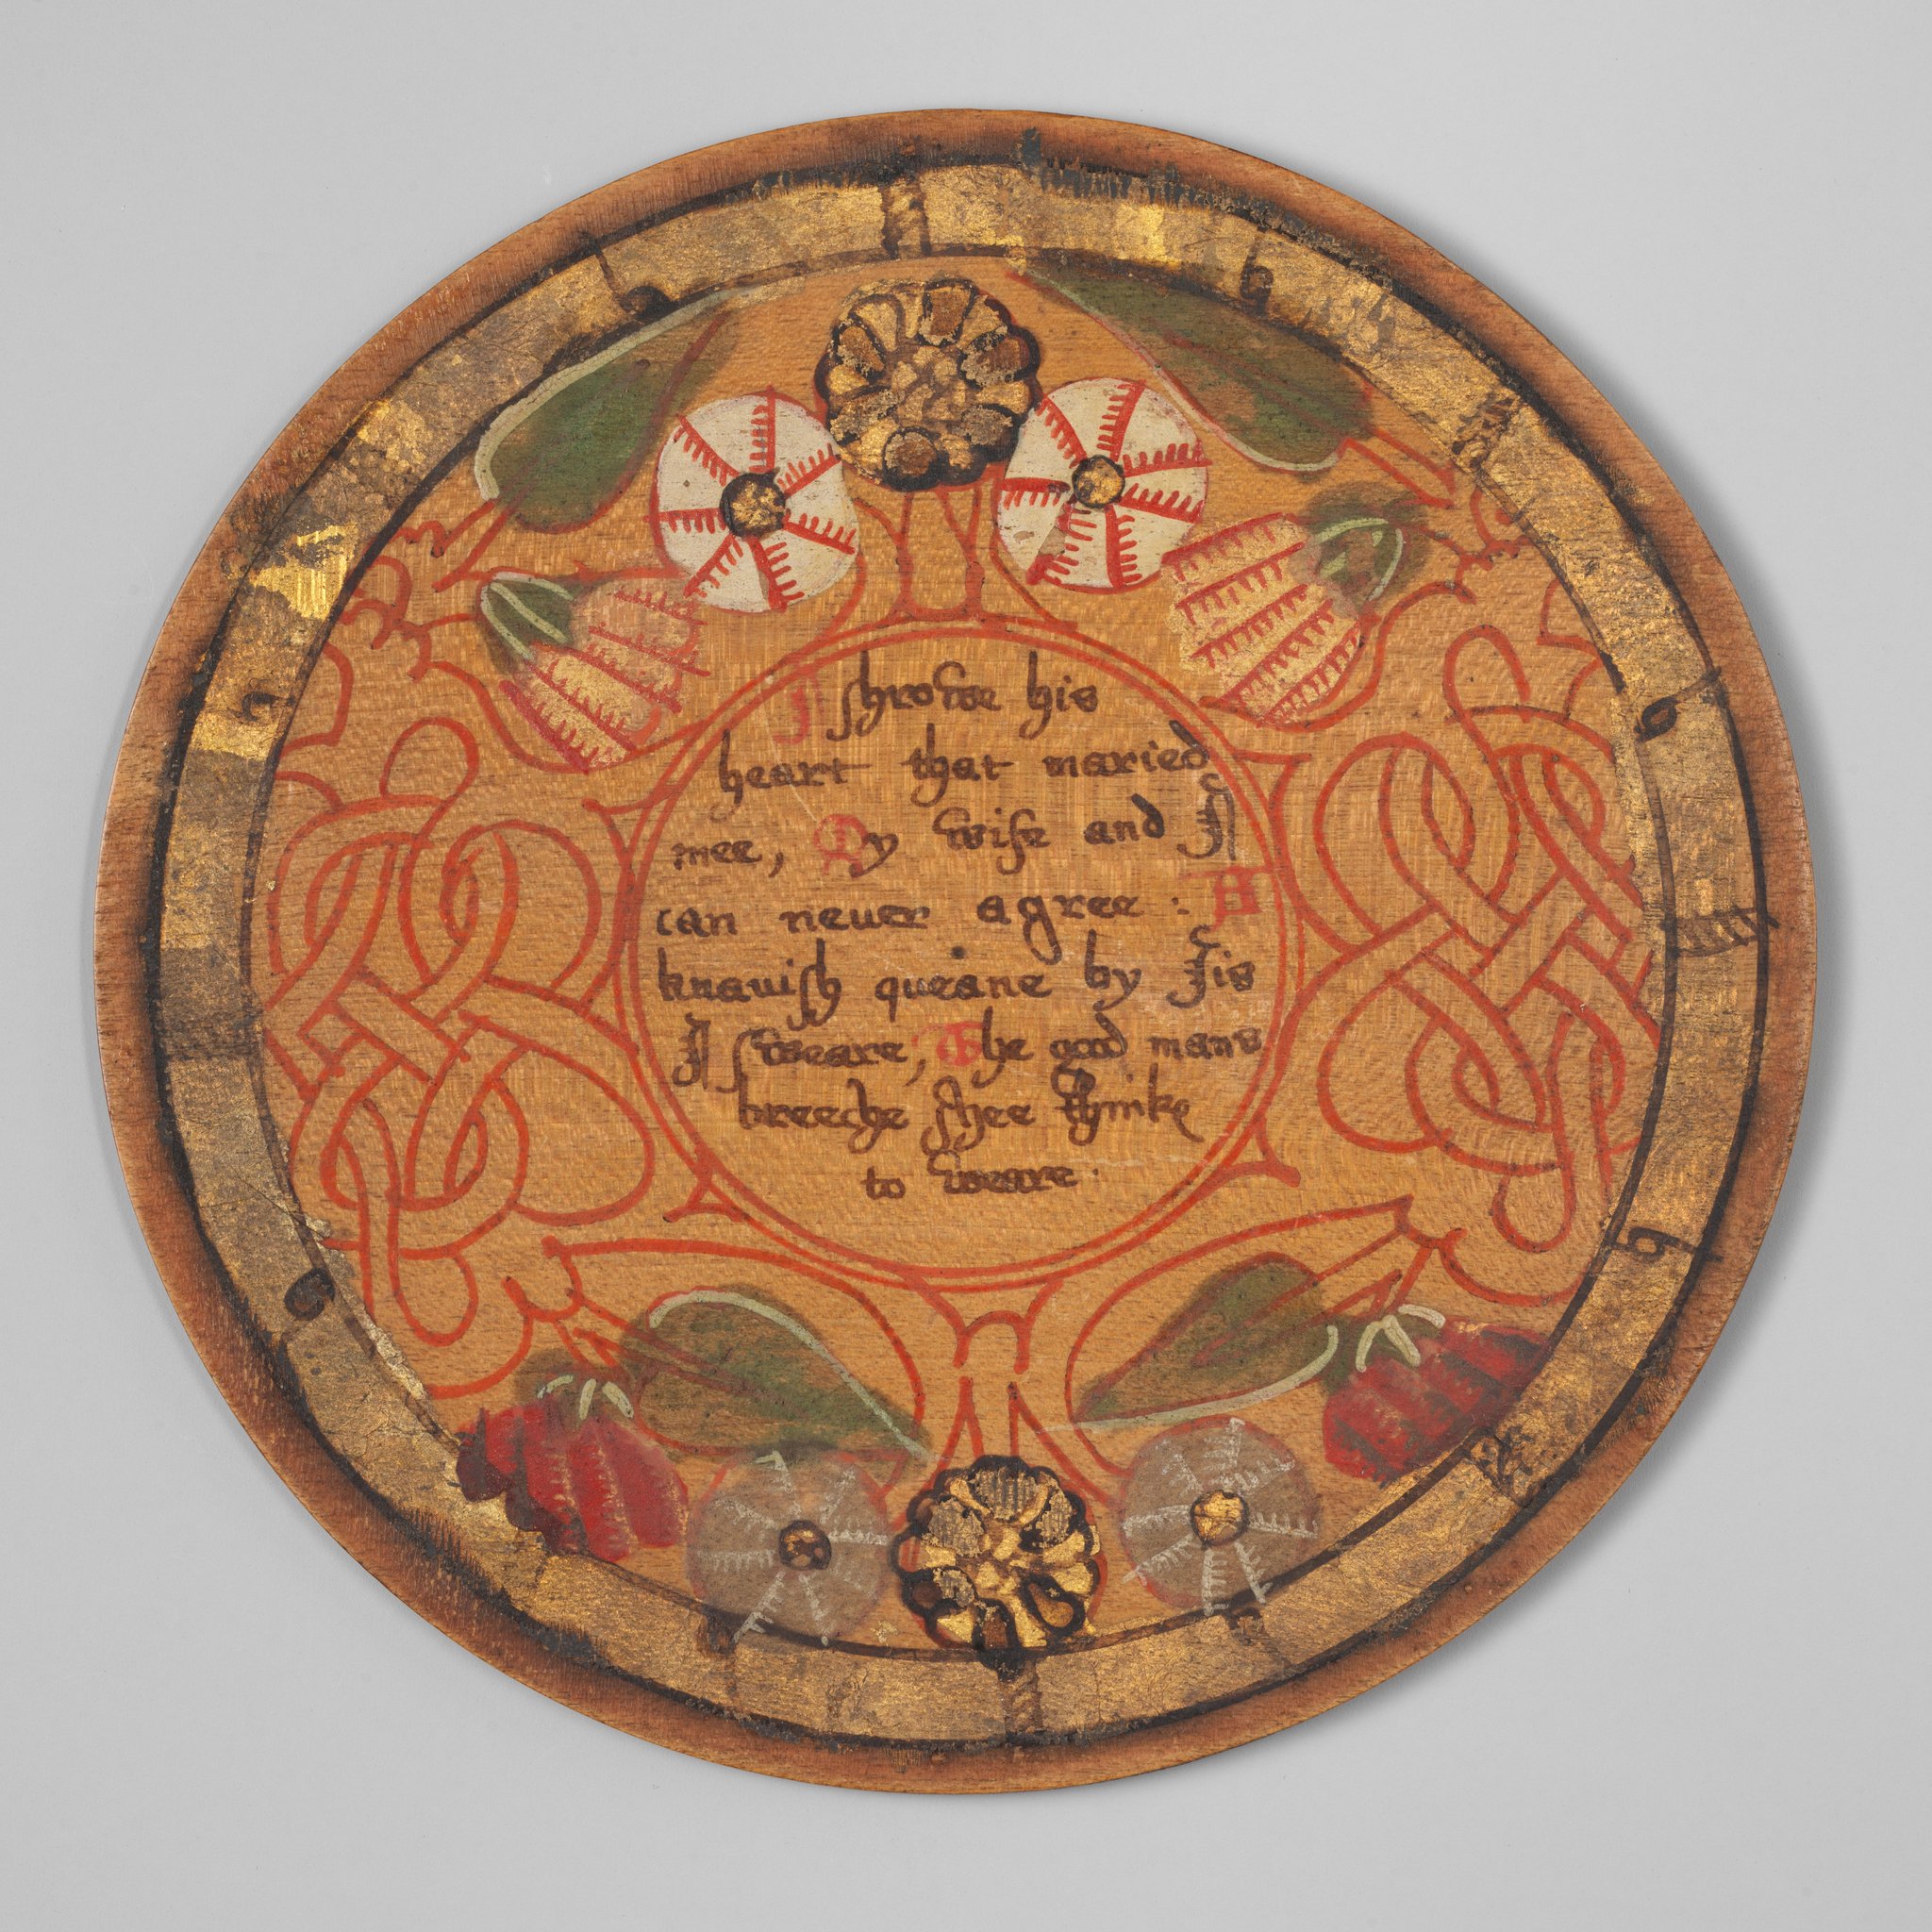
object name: trencher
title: Trencher (one of a set)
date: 1567-1633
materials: ink, wood, varnish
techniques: painting, silvered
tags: flowers